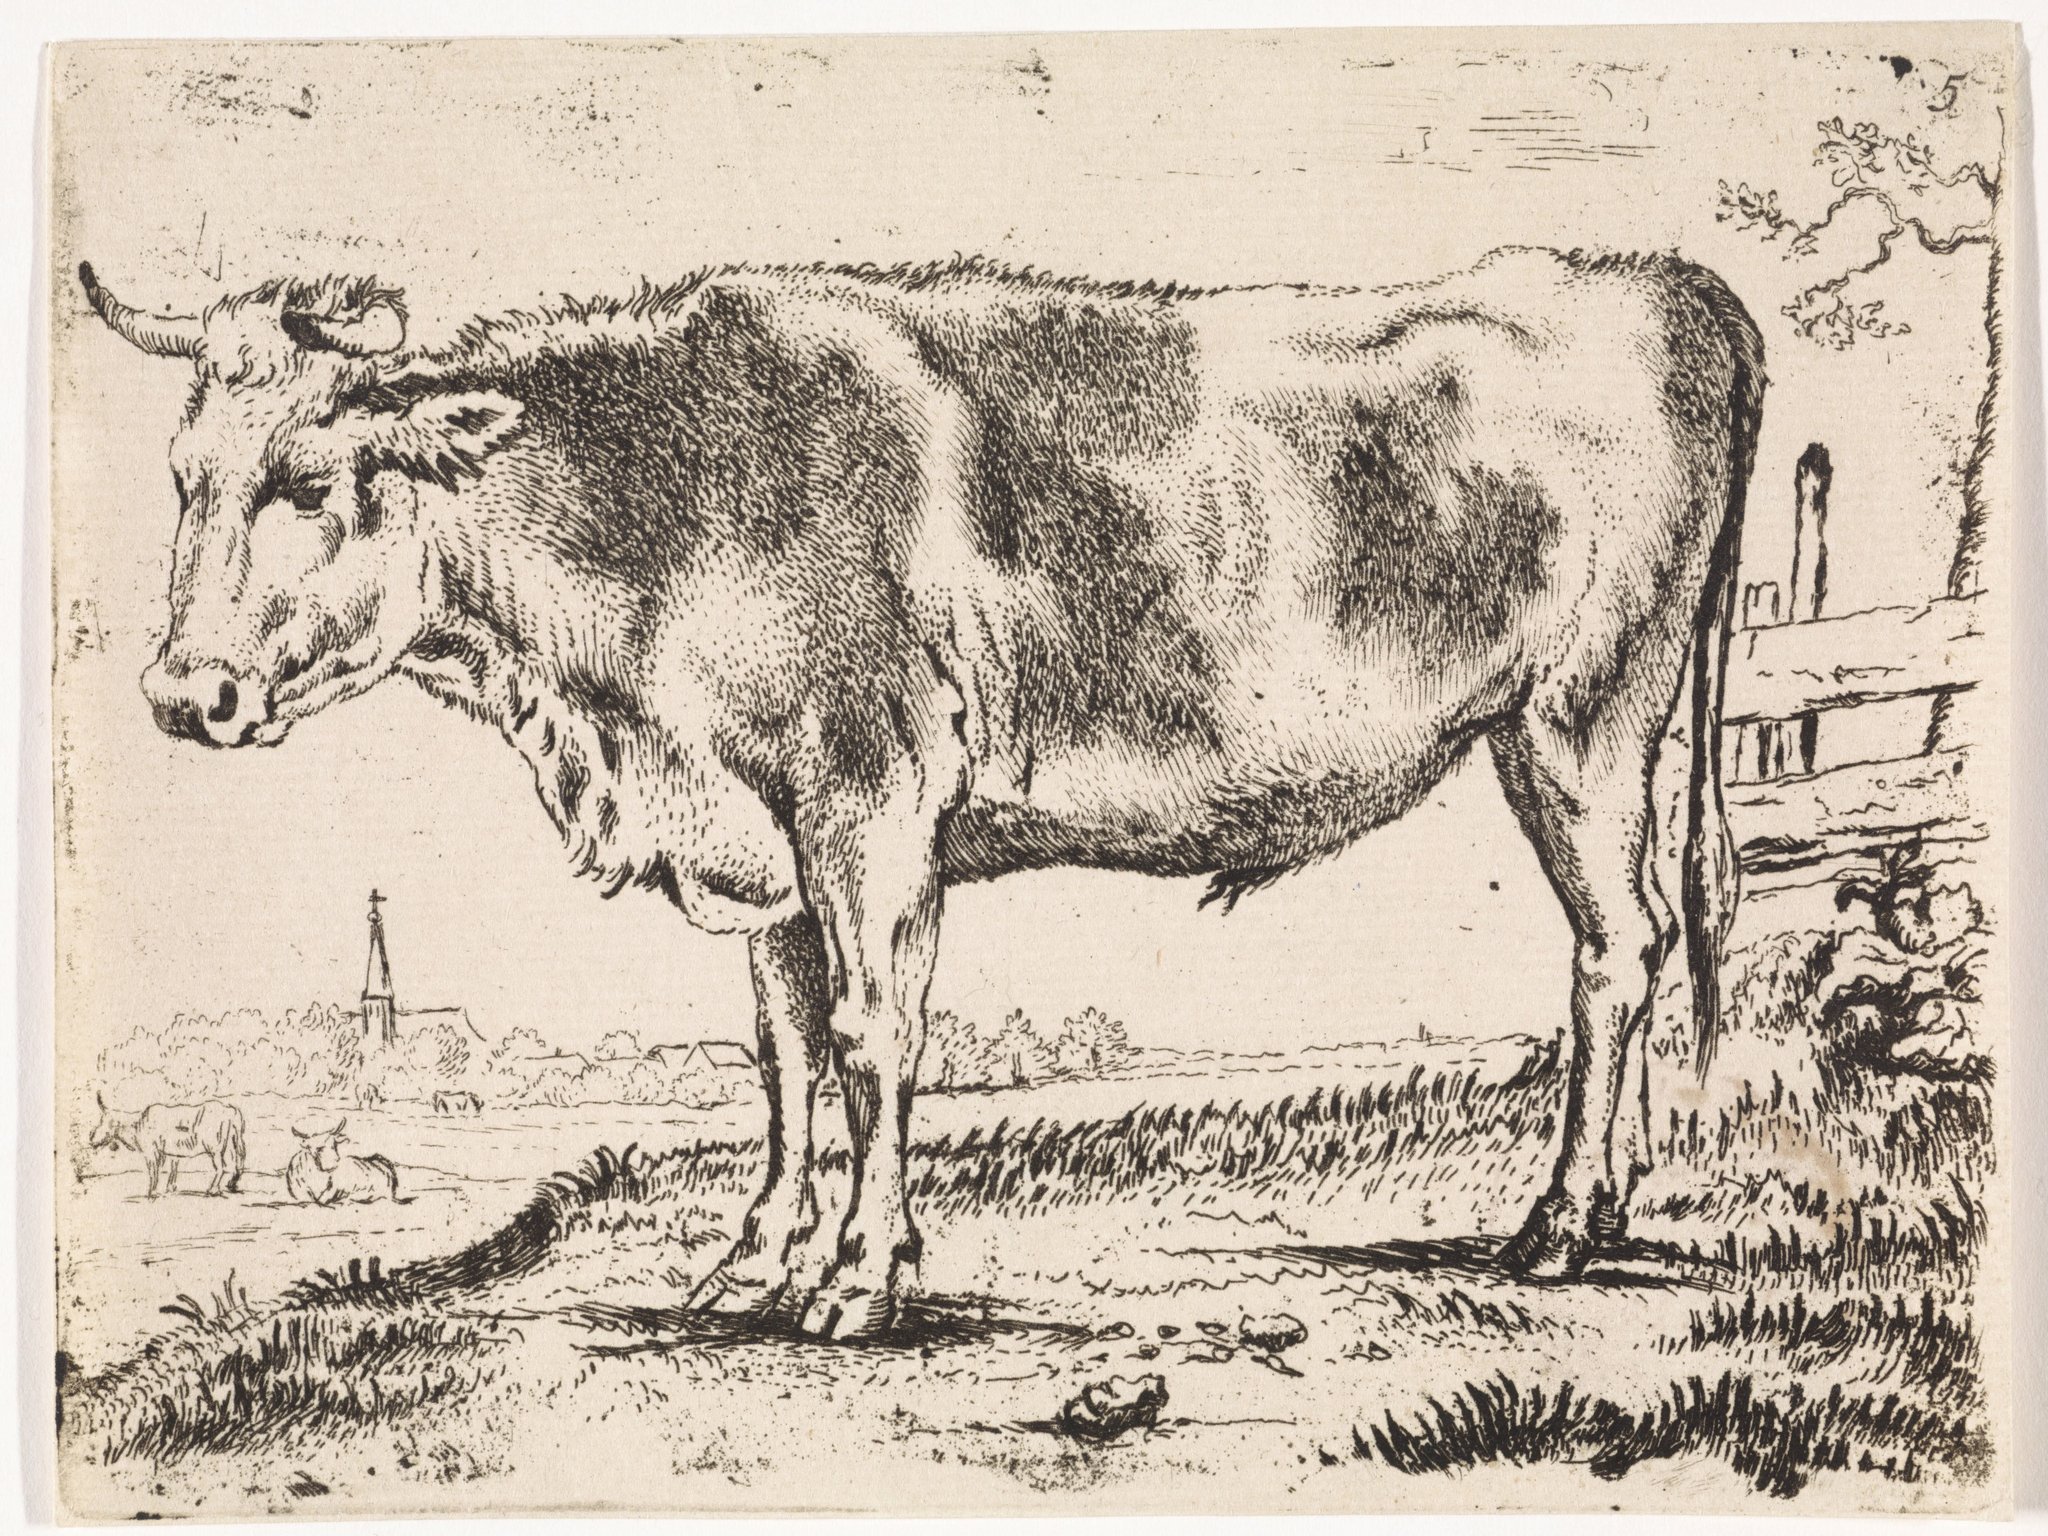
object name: print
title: Staande os, naar links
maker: frederik de wit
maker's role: print maker, printer, publisher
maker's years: 1629-1706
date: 1645-1706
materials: paper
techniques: etching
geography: amsterdam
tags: ox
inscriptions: collector's mark: Lugt 240